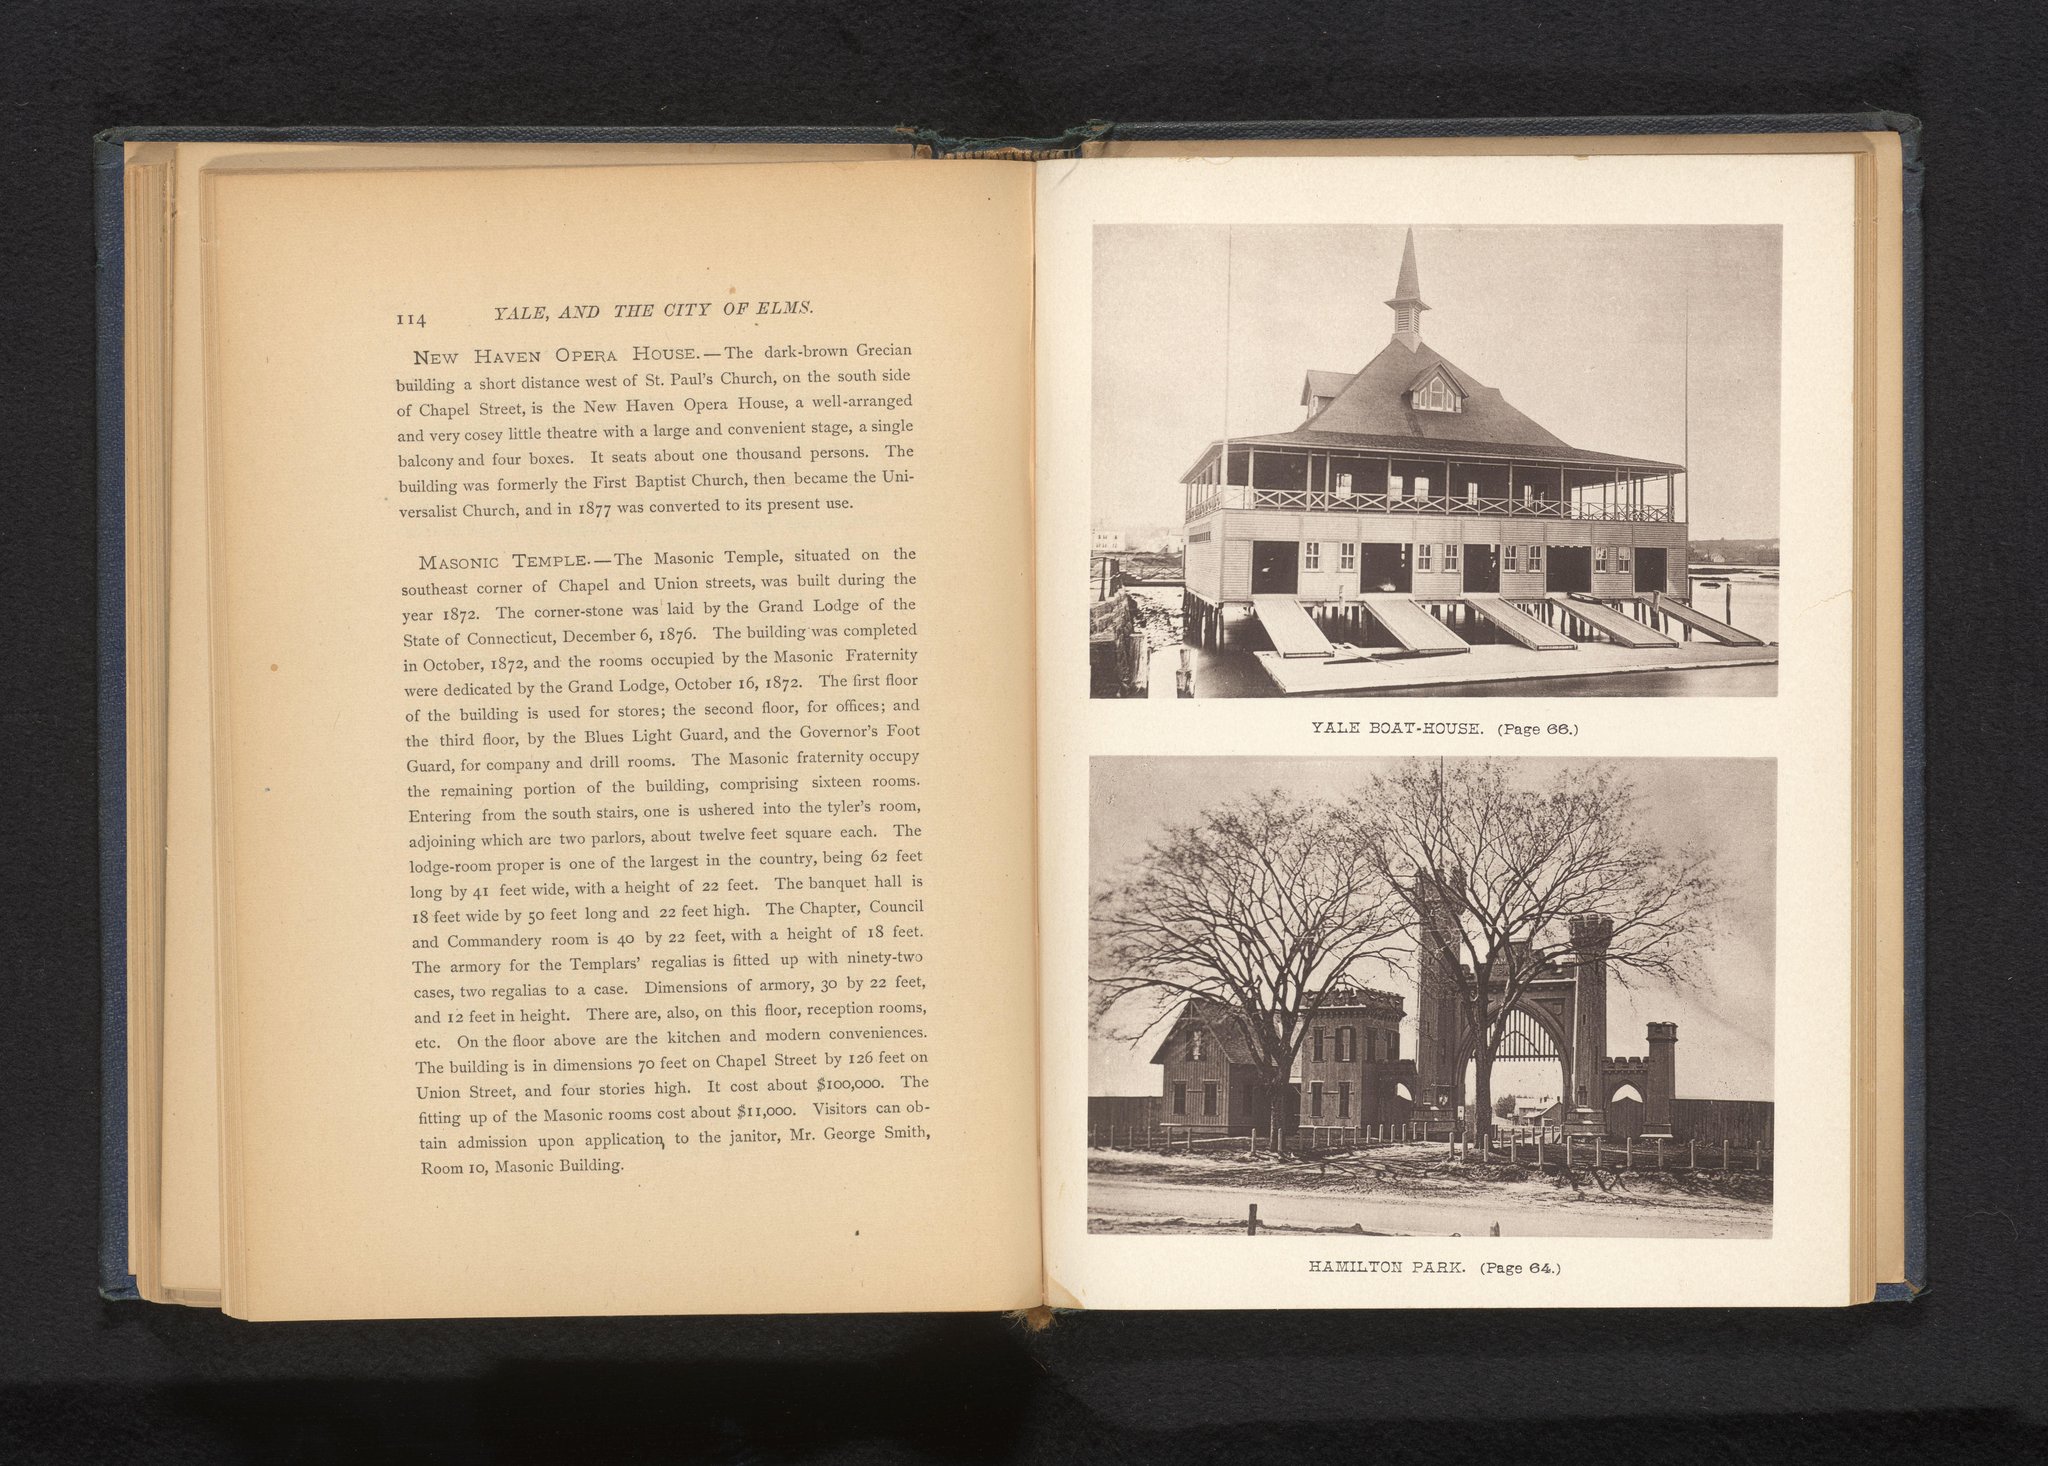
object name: photomechanical print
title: Hamilton Park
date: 1872-1882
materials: paper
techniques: photograph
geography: new haven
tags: boat-house, shed, façade (of house or building), public gardens, park